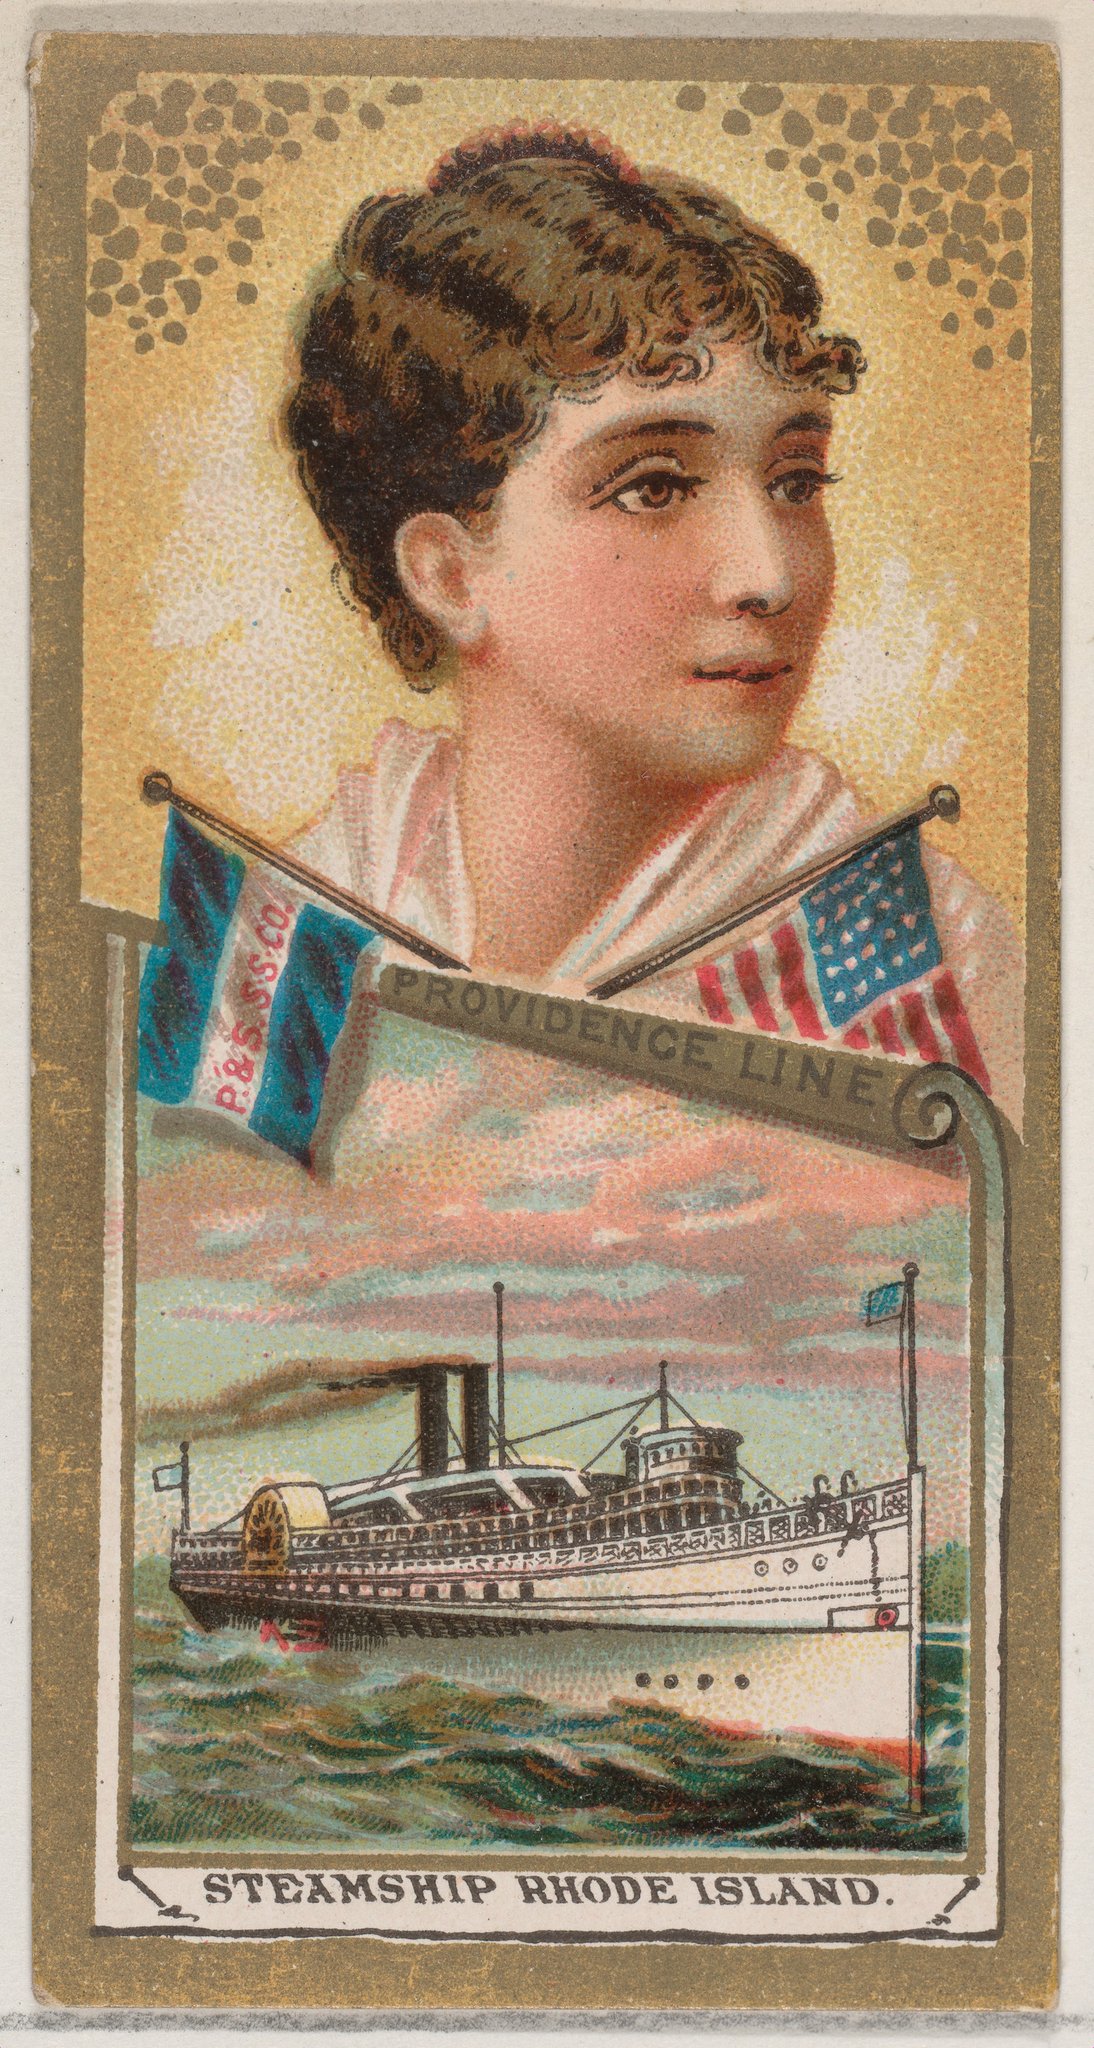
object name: print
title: Steamship Rhode Island, Providence Line, from the Ocean and River Steamers series (N83) for Duke brand cigarettes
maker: w. duke, sons & co.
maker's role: publisher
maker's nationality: american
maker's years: 1870-1920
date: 1887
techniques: color lithograph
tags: women,ships